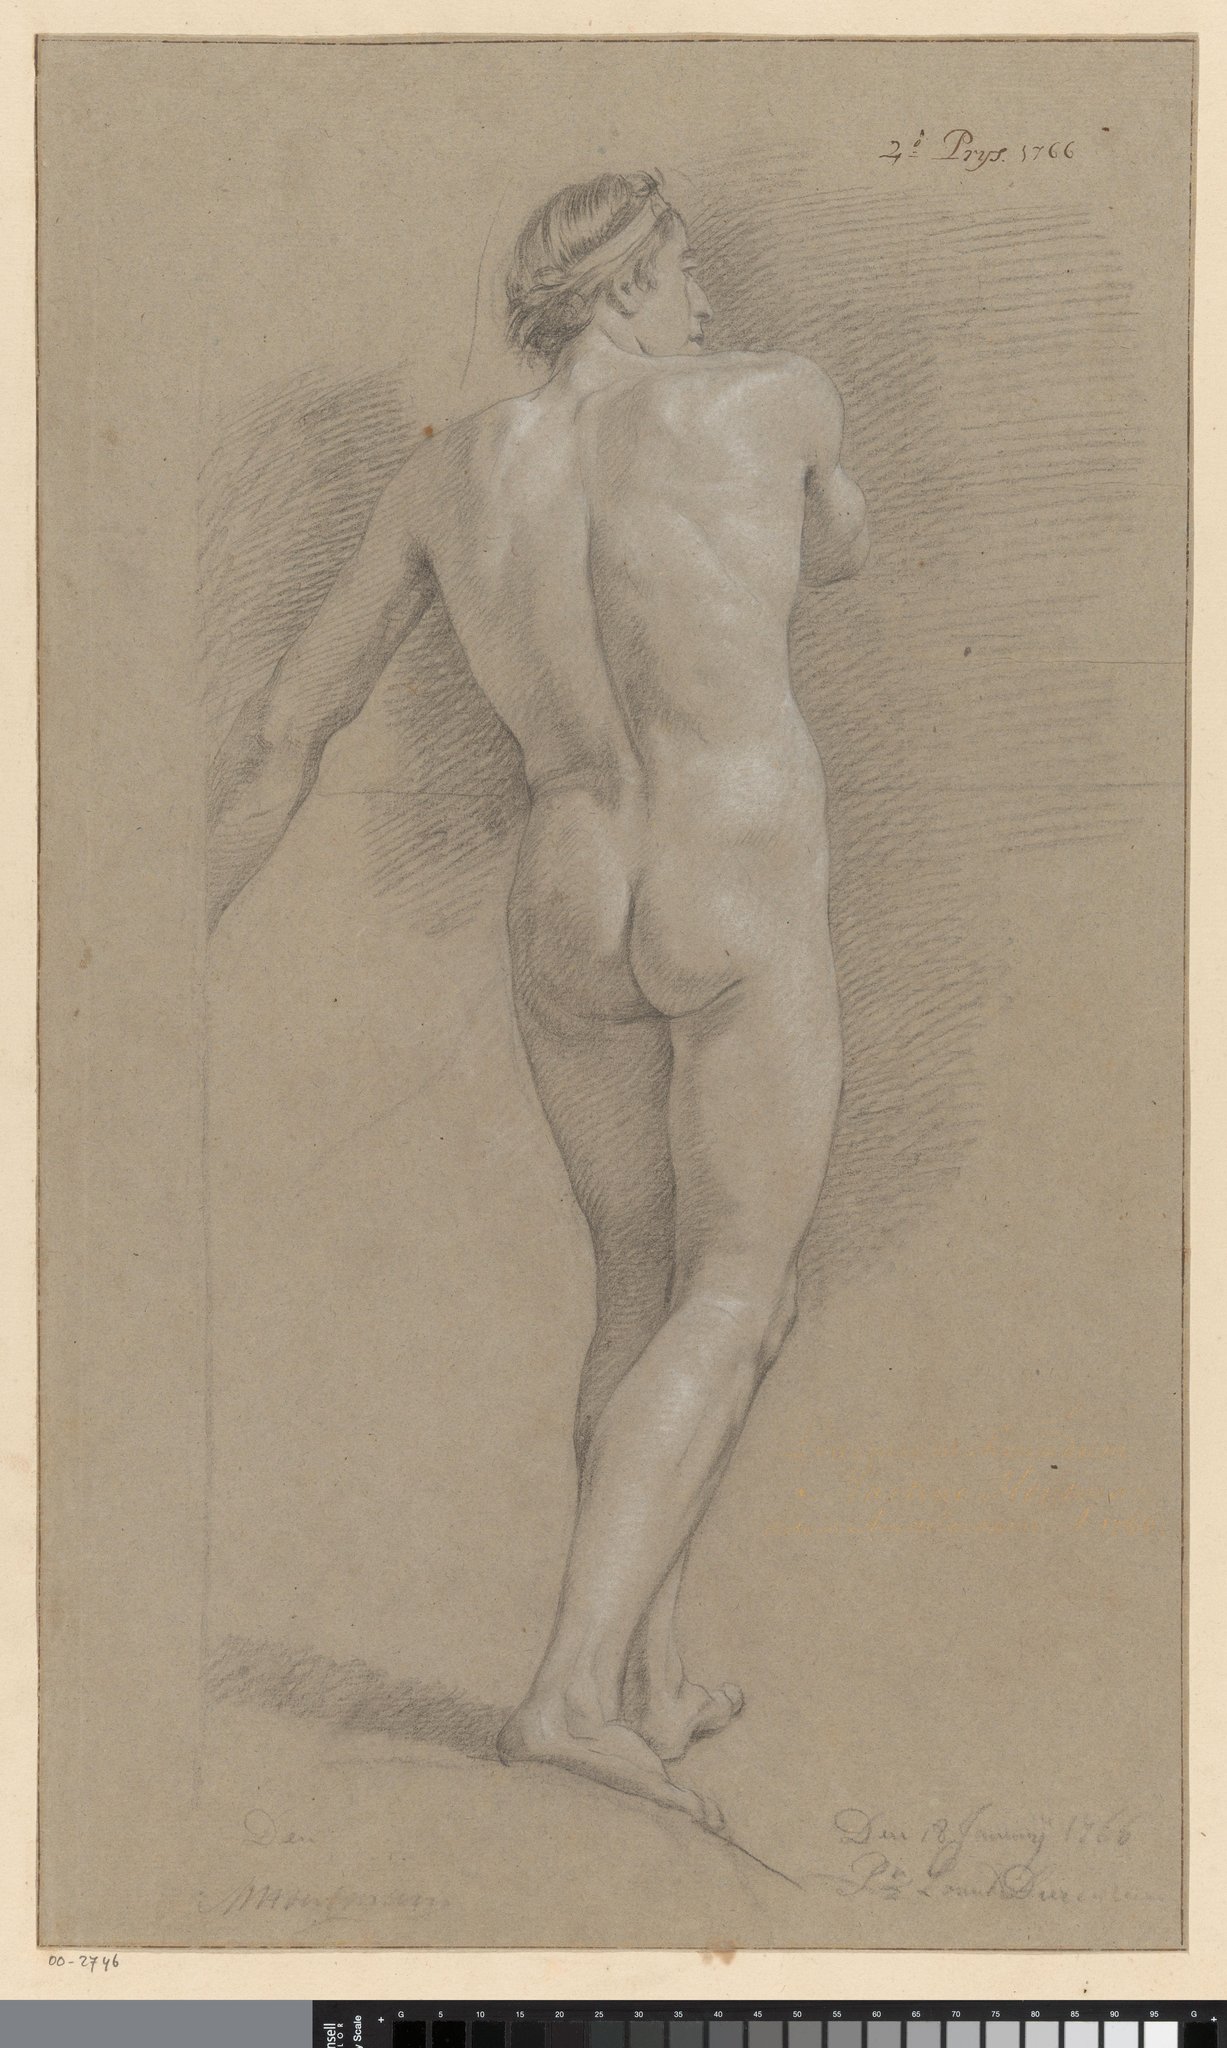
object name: drawing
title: Staand mannelijk naakt, op de rug gezien (2e prijs 1766)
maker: marten houtman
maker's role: draughtsman, print maker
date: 1766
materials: chalk, paper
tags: standing figure (+ nude human being)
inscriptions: date: ‘18 January 1766’